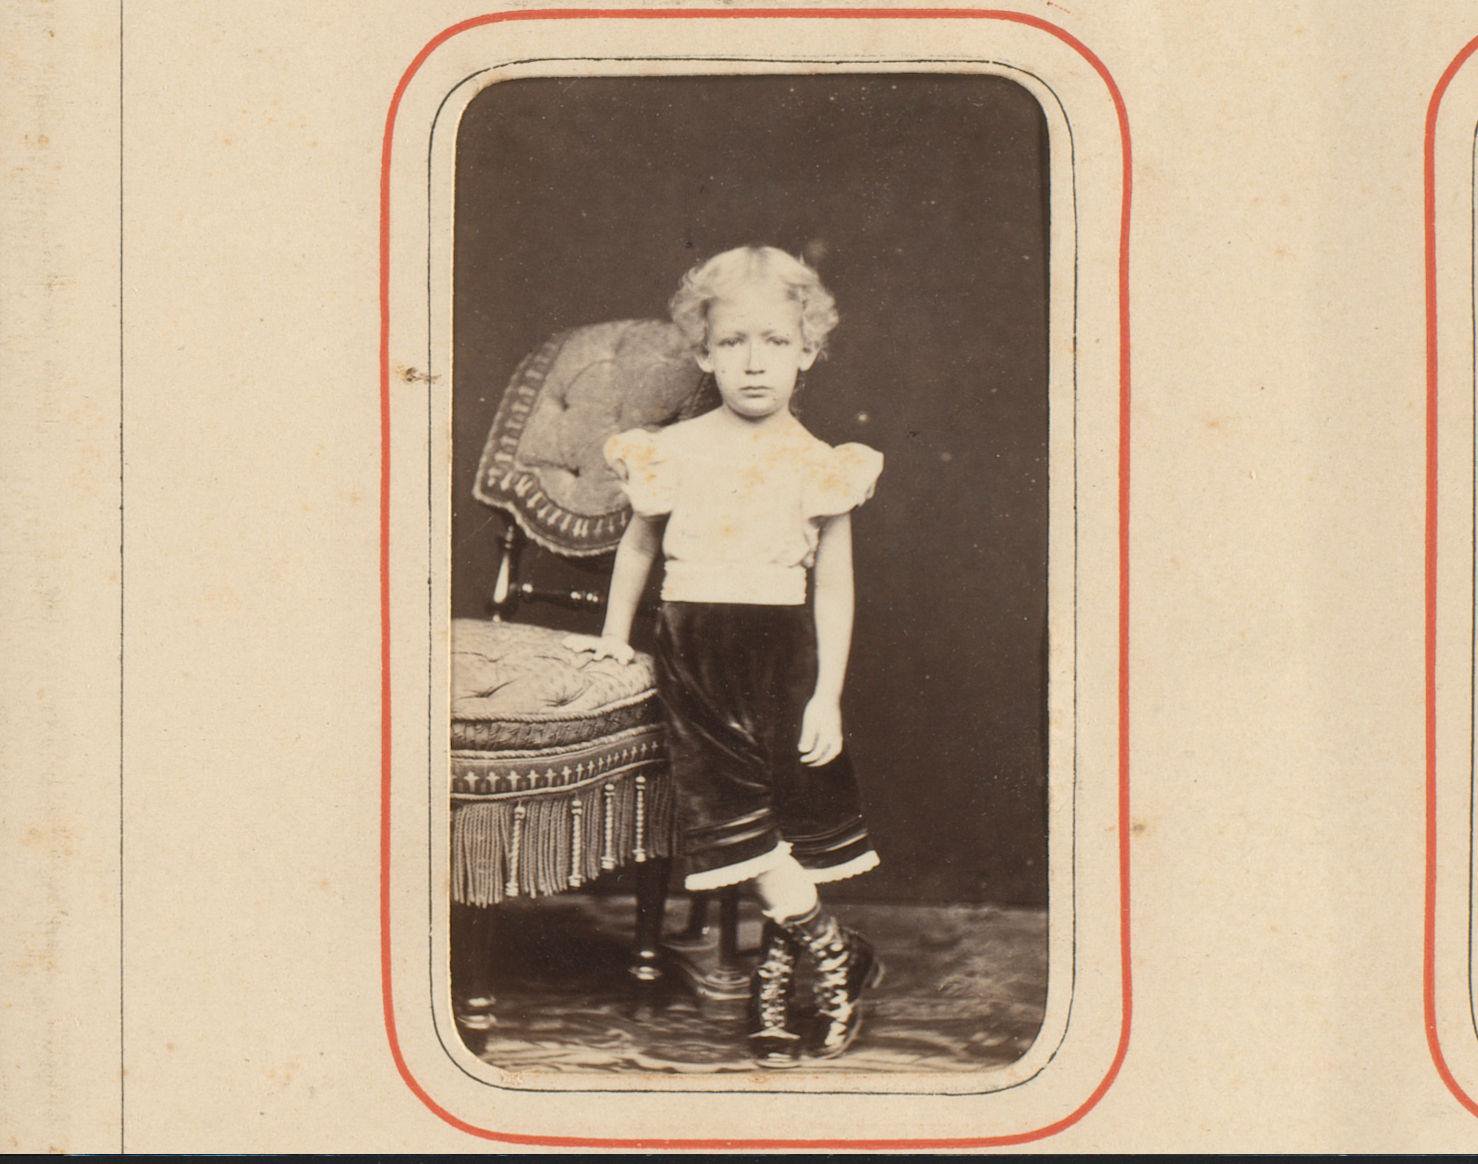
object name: carte de visite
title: Portret van een onbekend kind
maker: j.b. jasper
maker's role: fotograaf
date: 1870-1899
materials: cardboard, paper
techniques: albumen print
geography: surabaya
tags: anonymous historical person portrayed